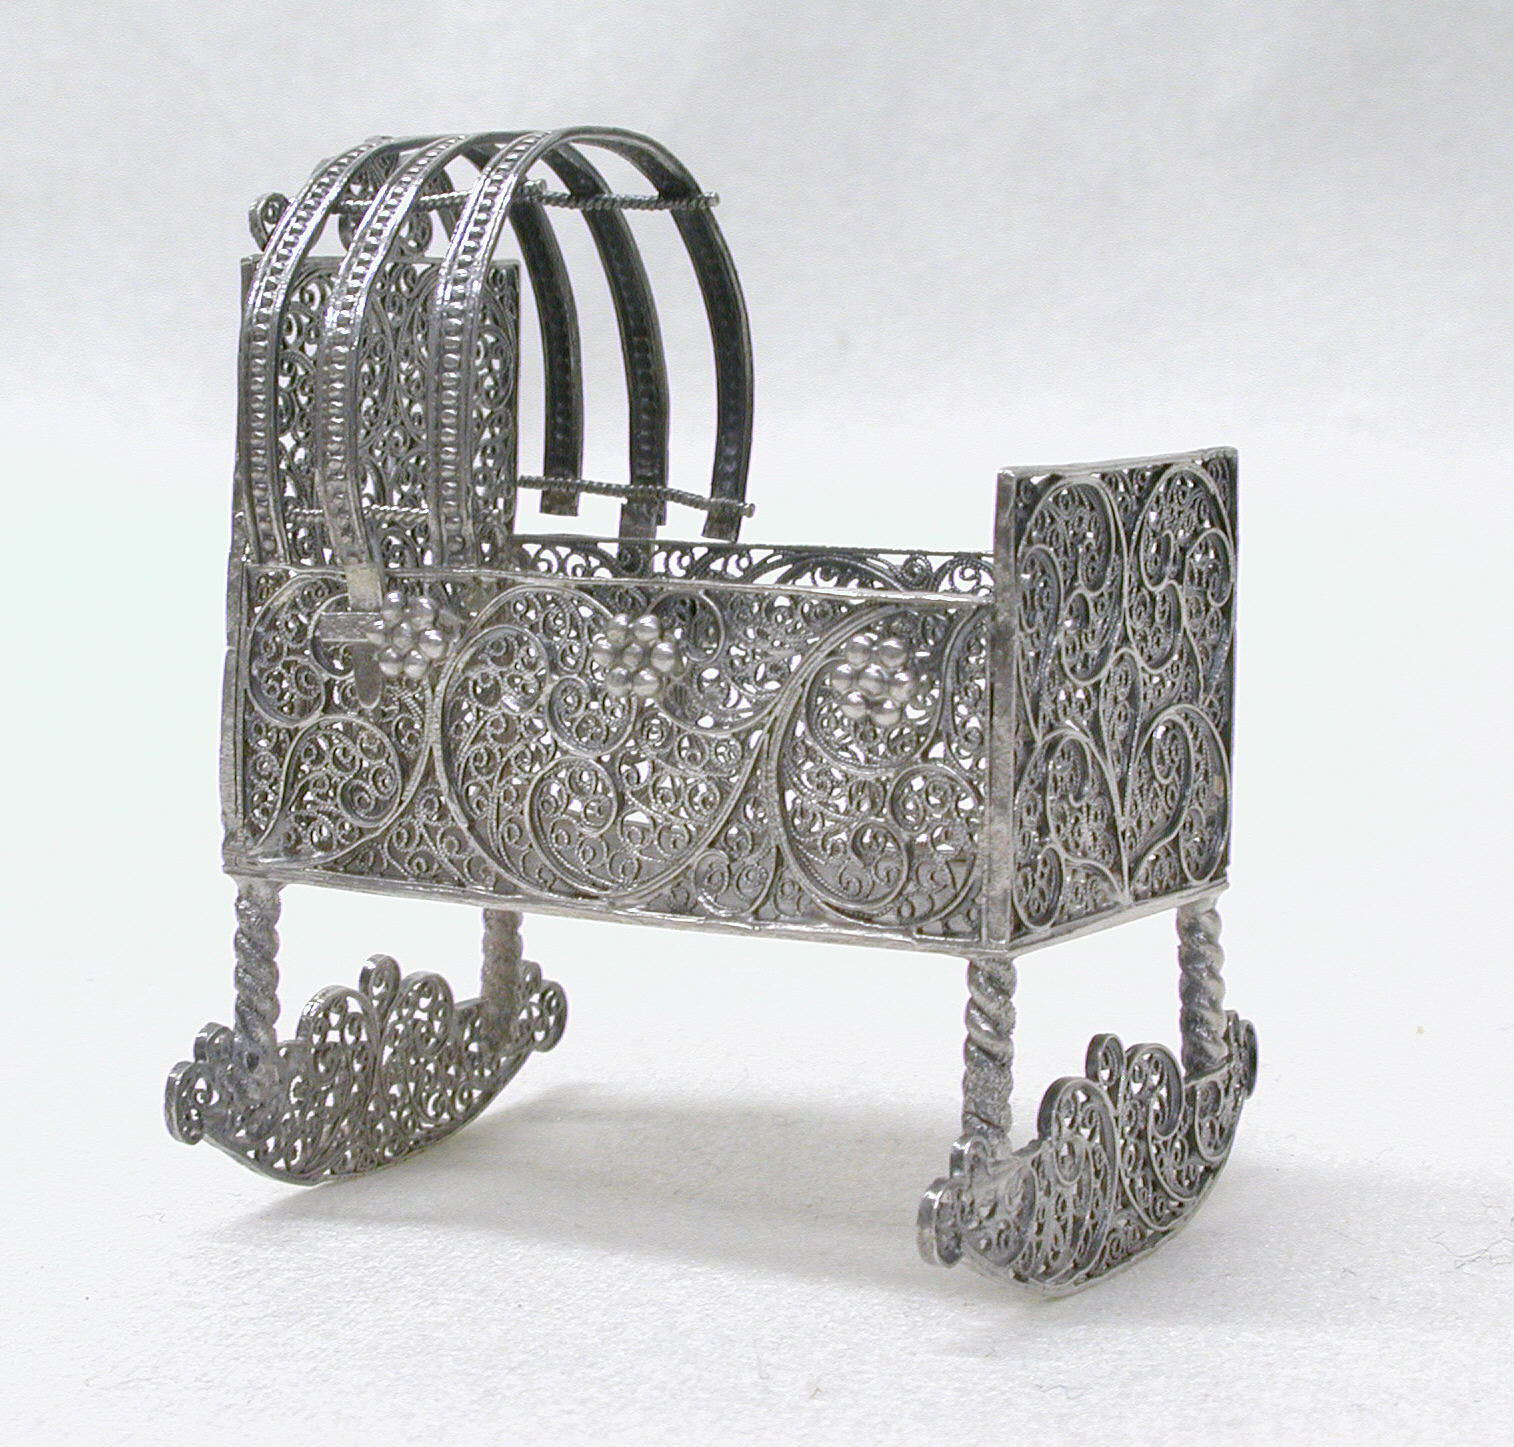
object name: cradle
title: Miniature cradle (part of a set)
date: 1675-1700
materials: silver